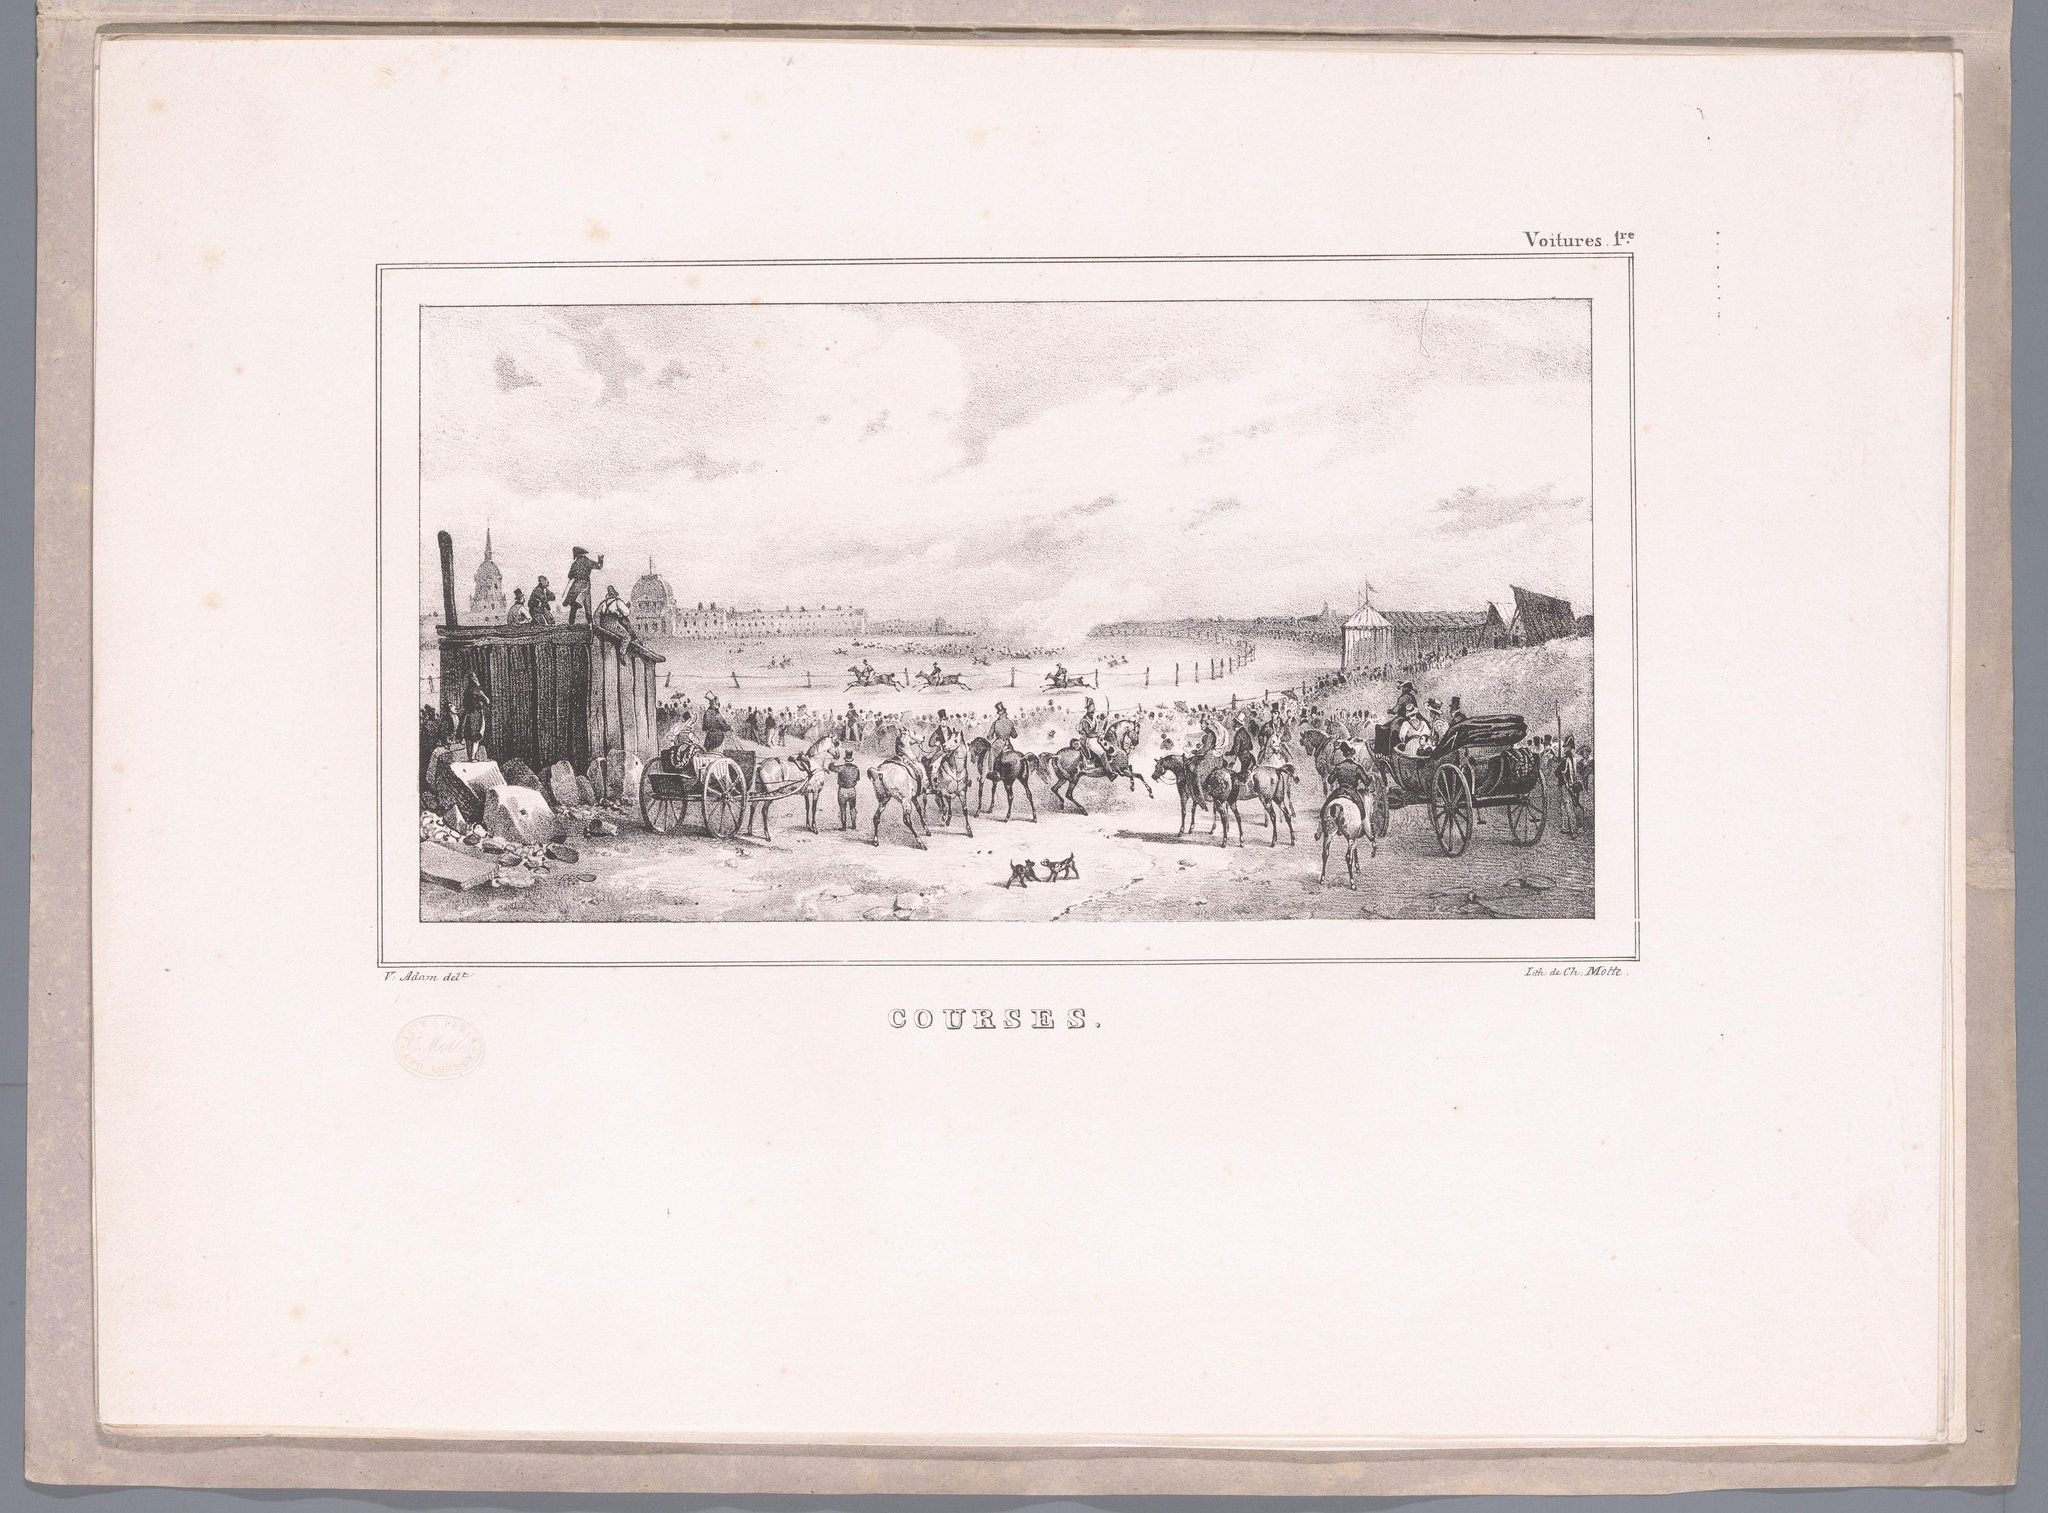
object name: print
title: Toeschouwers bij een paardenrenbaan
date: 1827-1828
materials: paper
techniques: lithography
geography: paris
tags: horse-racing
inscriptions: stamp: Lugt 1828b, collector's mark: Lugt 2228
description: De prentserie waar deze prent deel van uitmaakt werd in drie delen van twaalf prenten vanaf 1827 tot en met 1830 gepubliceerd. Elk van de drie delen werd voorzien van een aparte omslag.